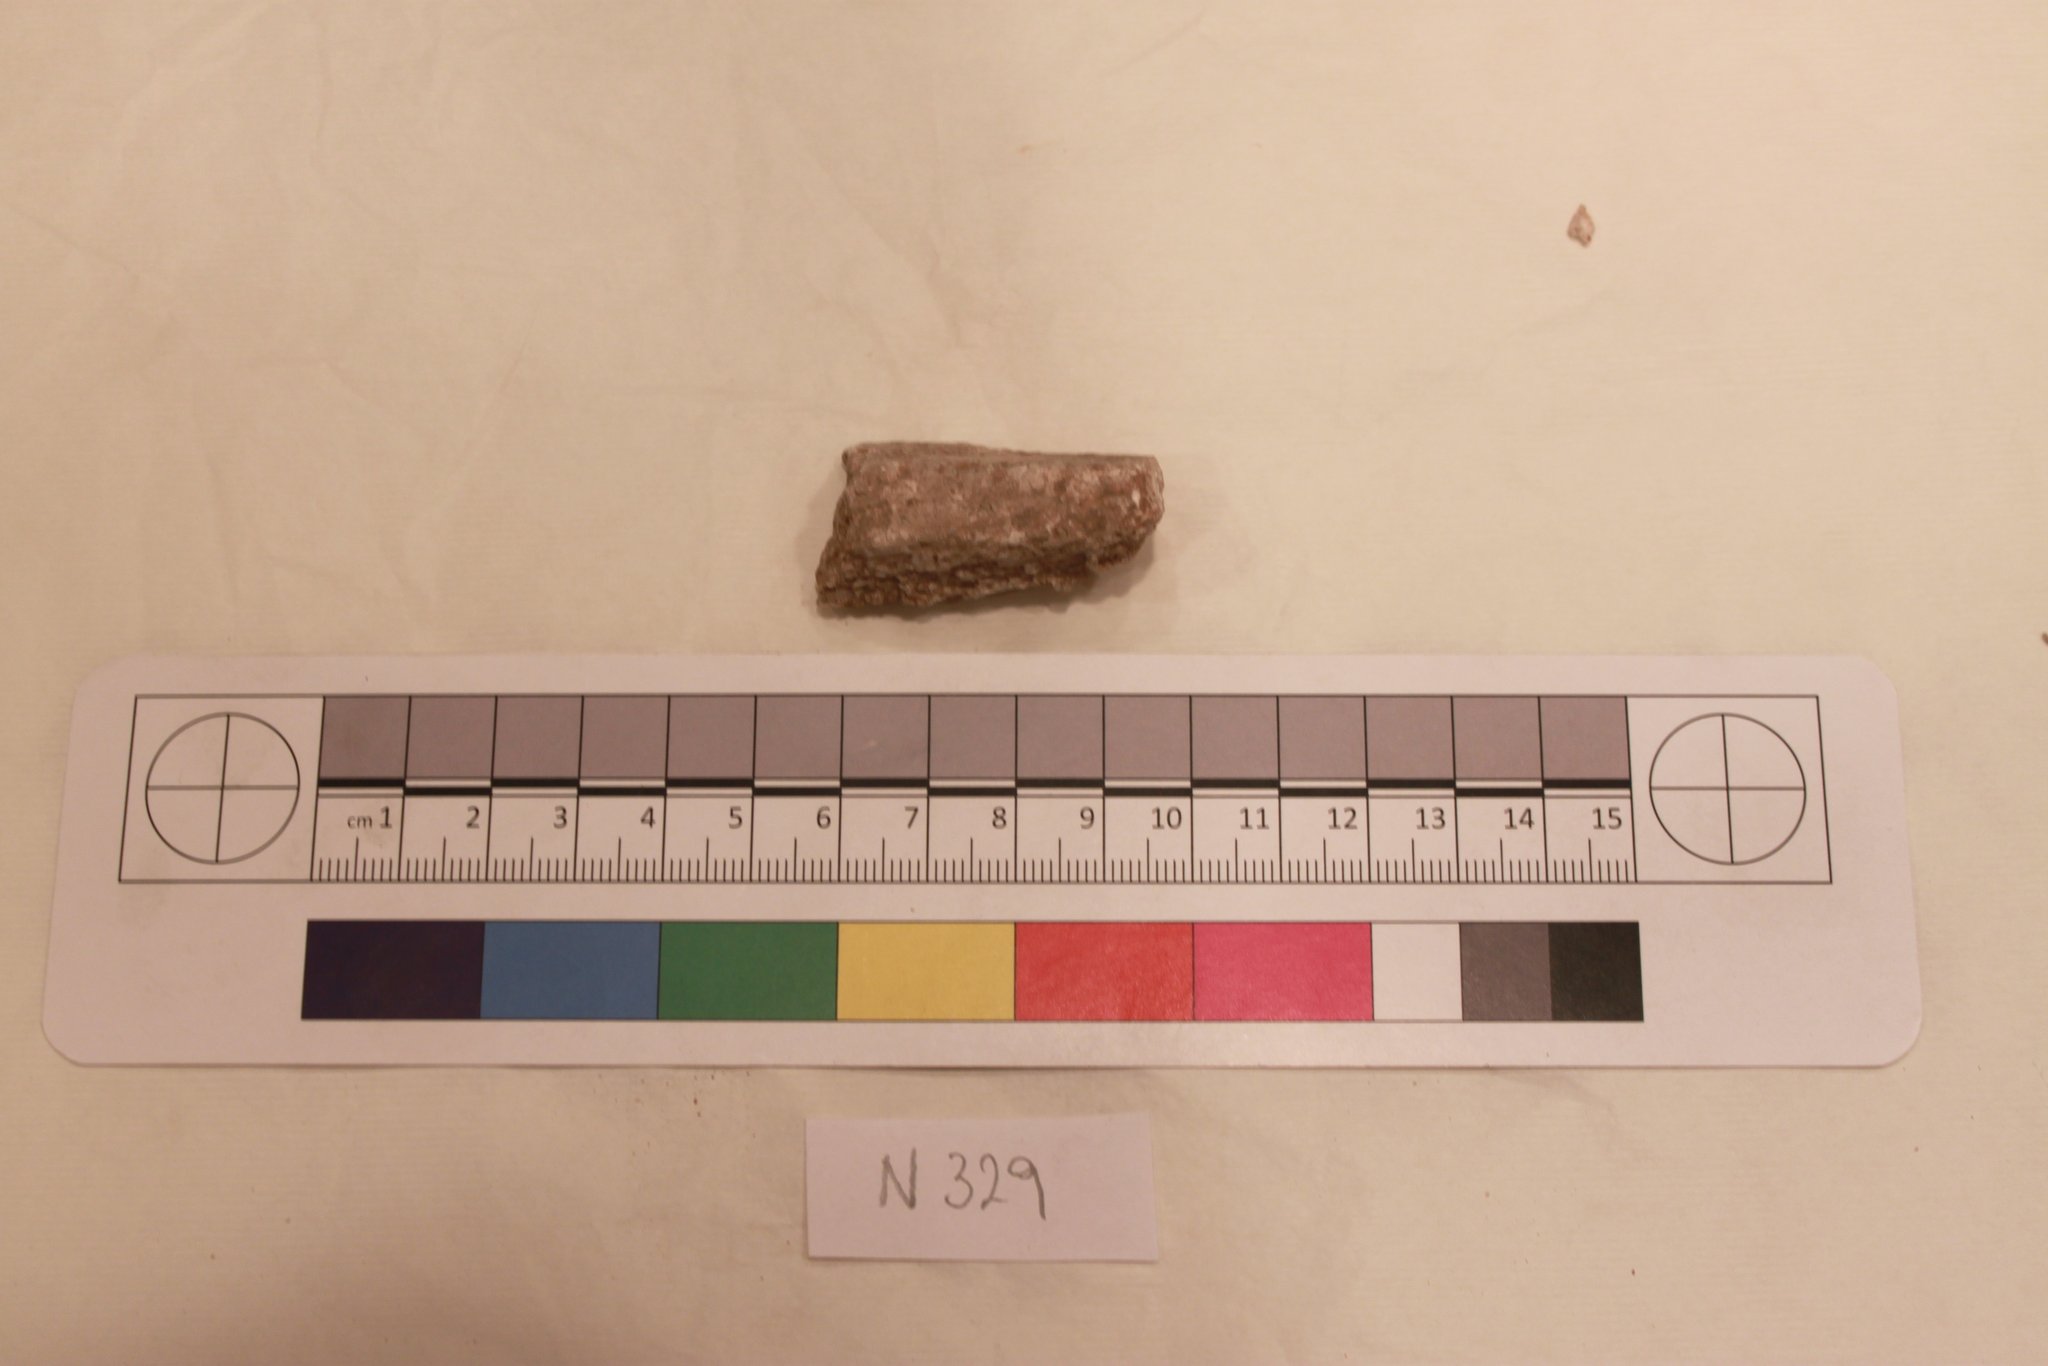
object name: fragment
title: Stucco Fragment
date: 701-1200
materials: plaster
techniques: carving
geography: iran